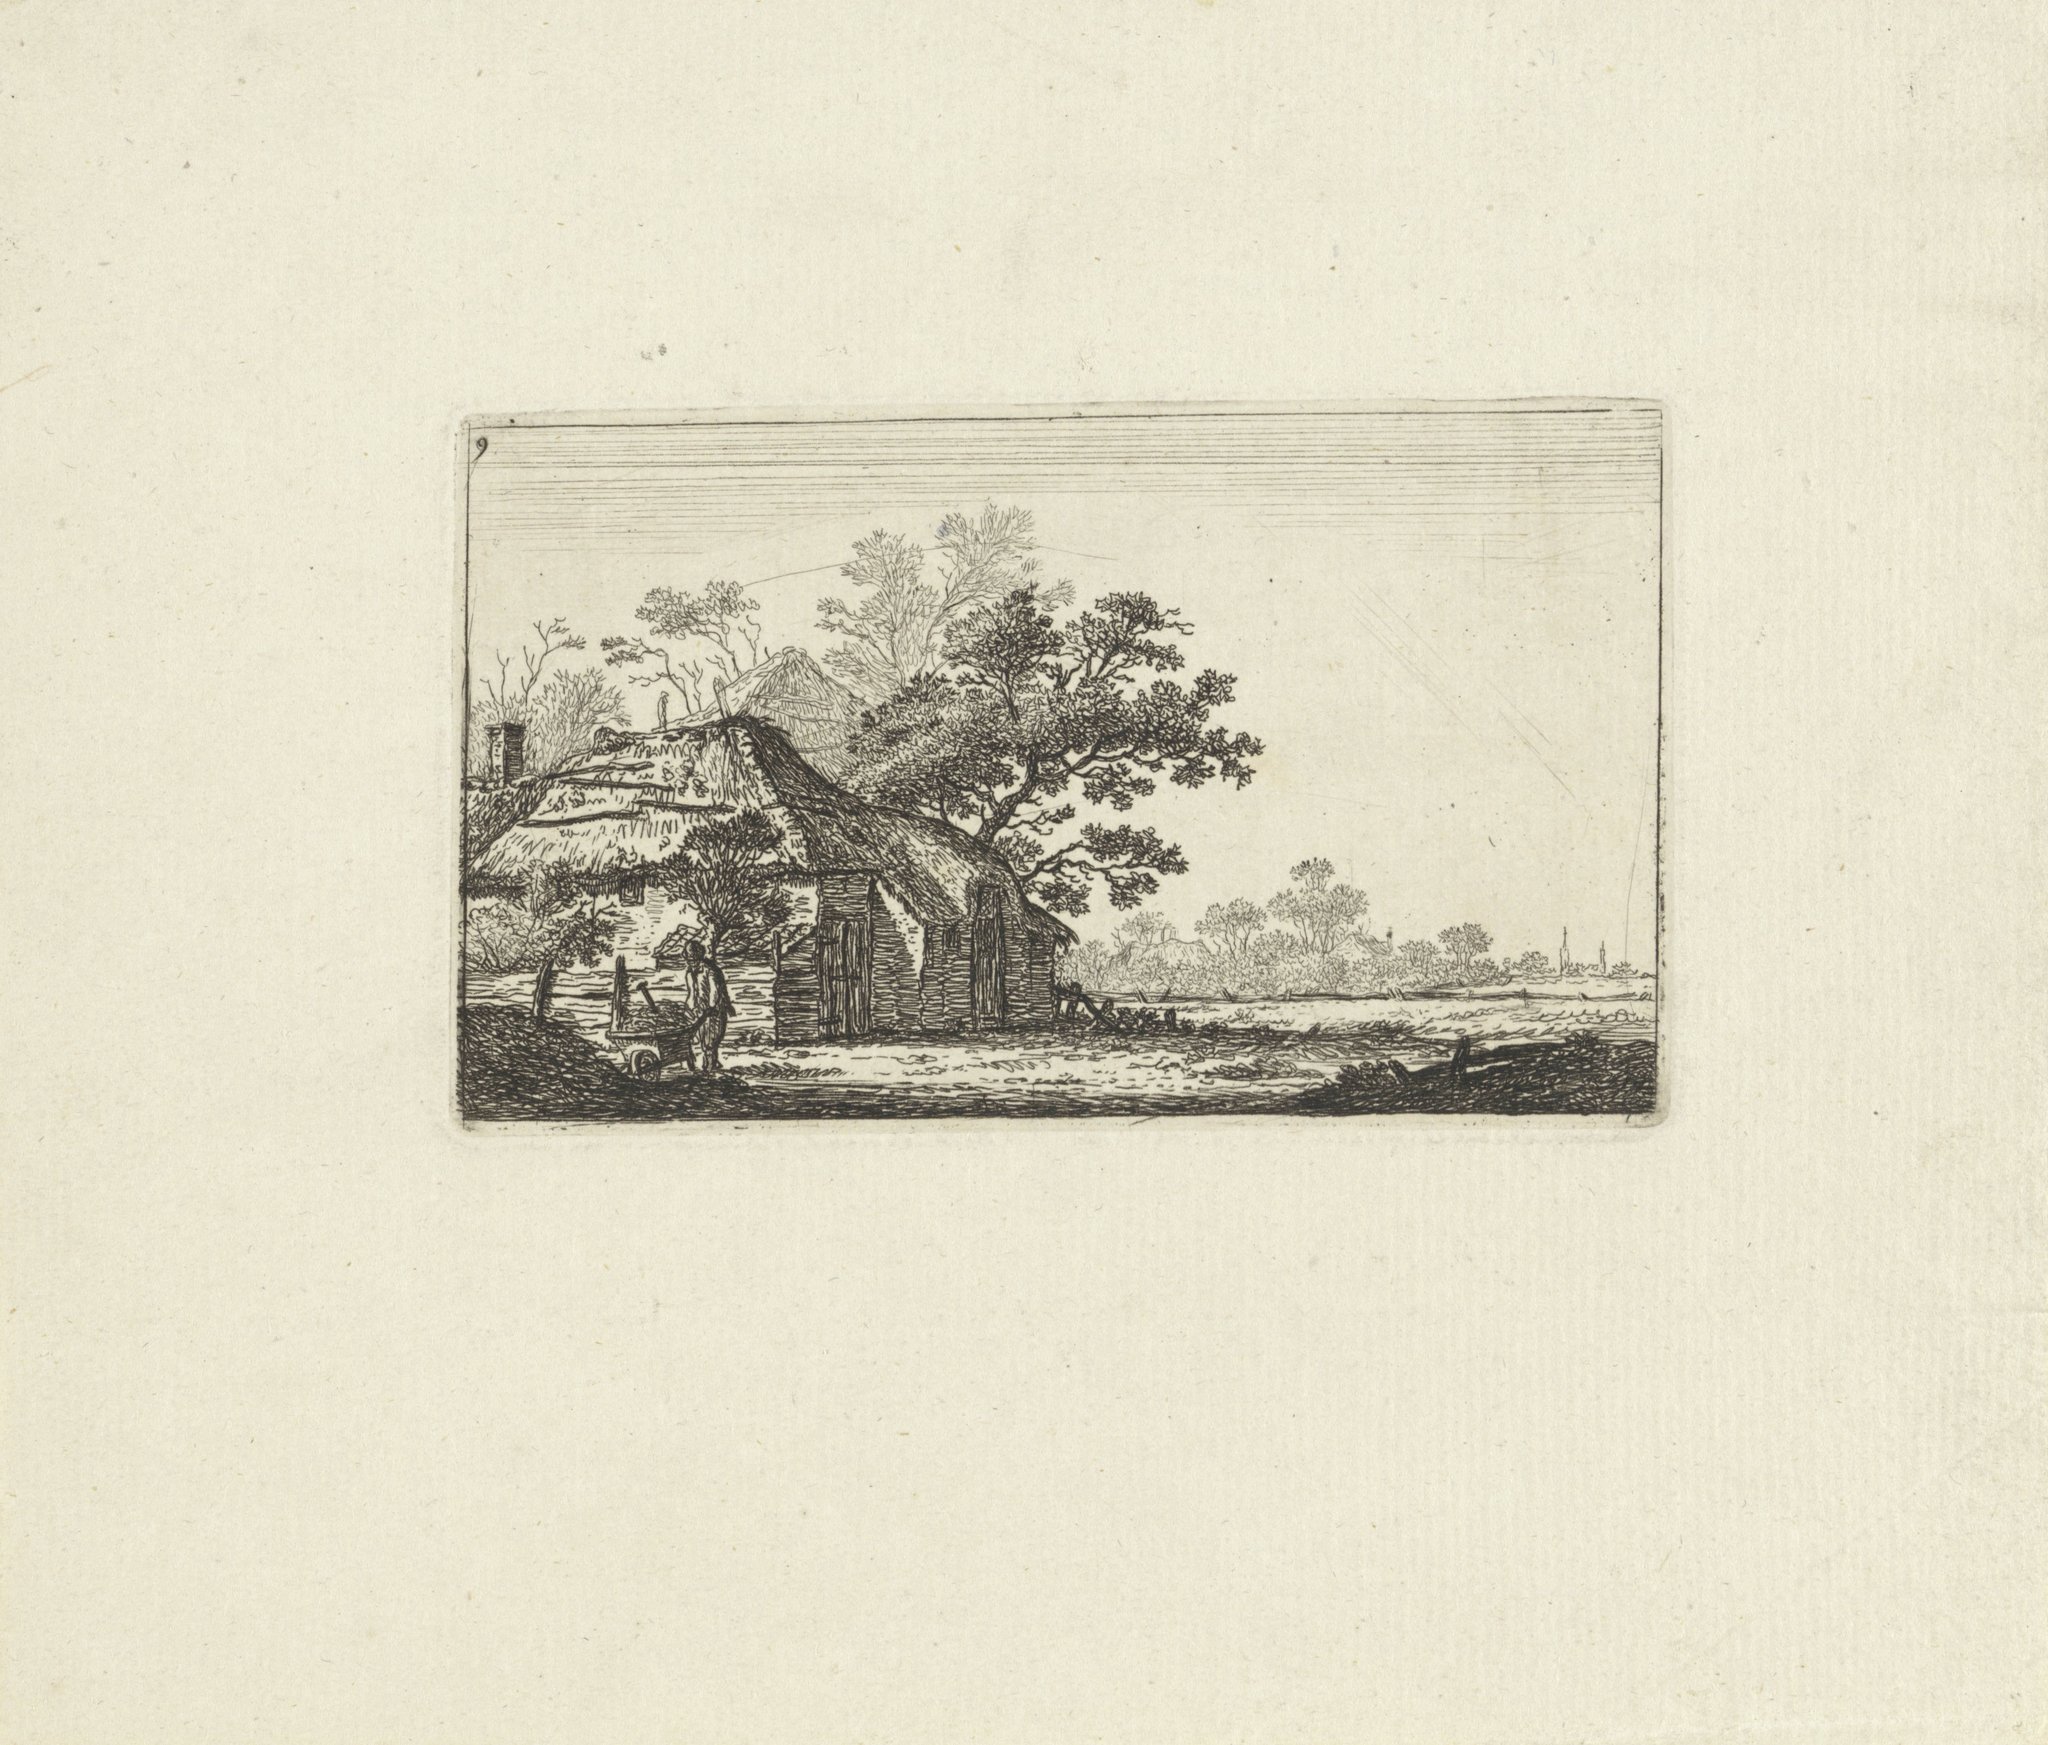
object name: print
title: Landschappen met woningen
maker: hendrik schwegman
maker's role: draughtsman, print maker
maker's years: 1761-1816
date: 1786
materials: paper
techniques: etching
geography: haarlem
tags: wheelbarrow, farm or solitary house in landscape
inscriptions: collector's mark: Lugt 2228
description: Landschap met een boerderij en een boer met kruiwagen. Rechts weilanden.